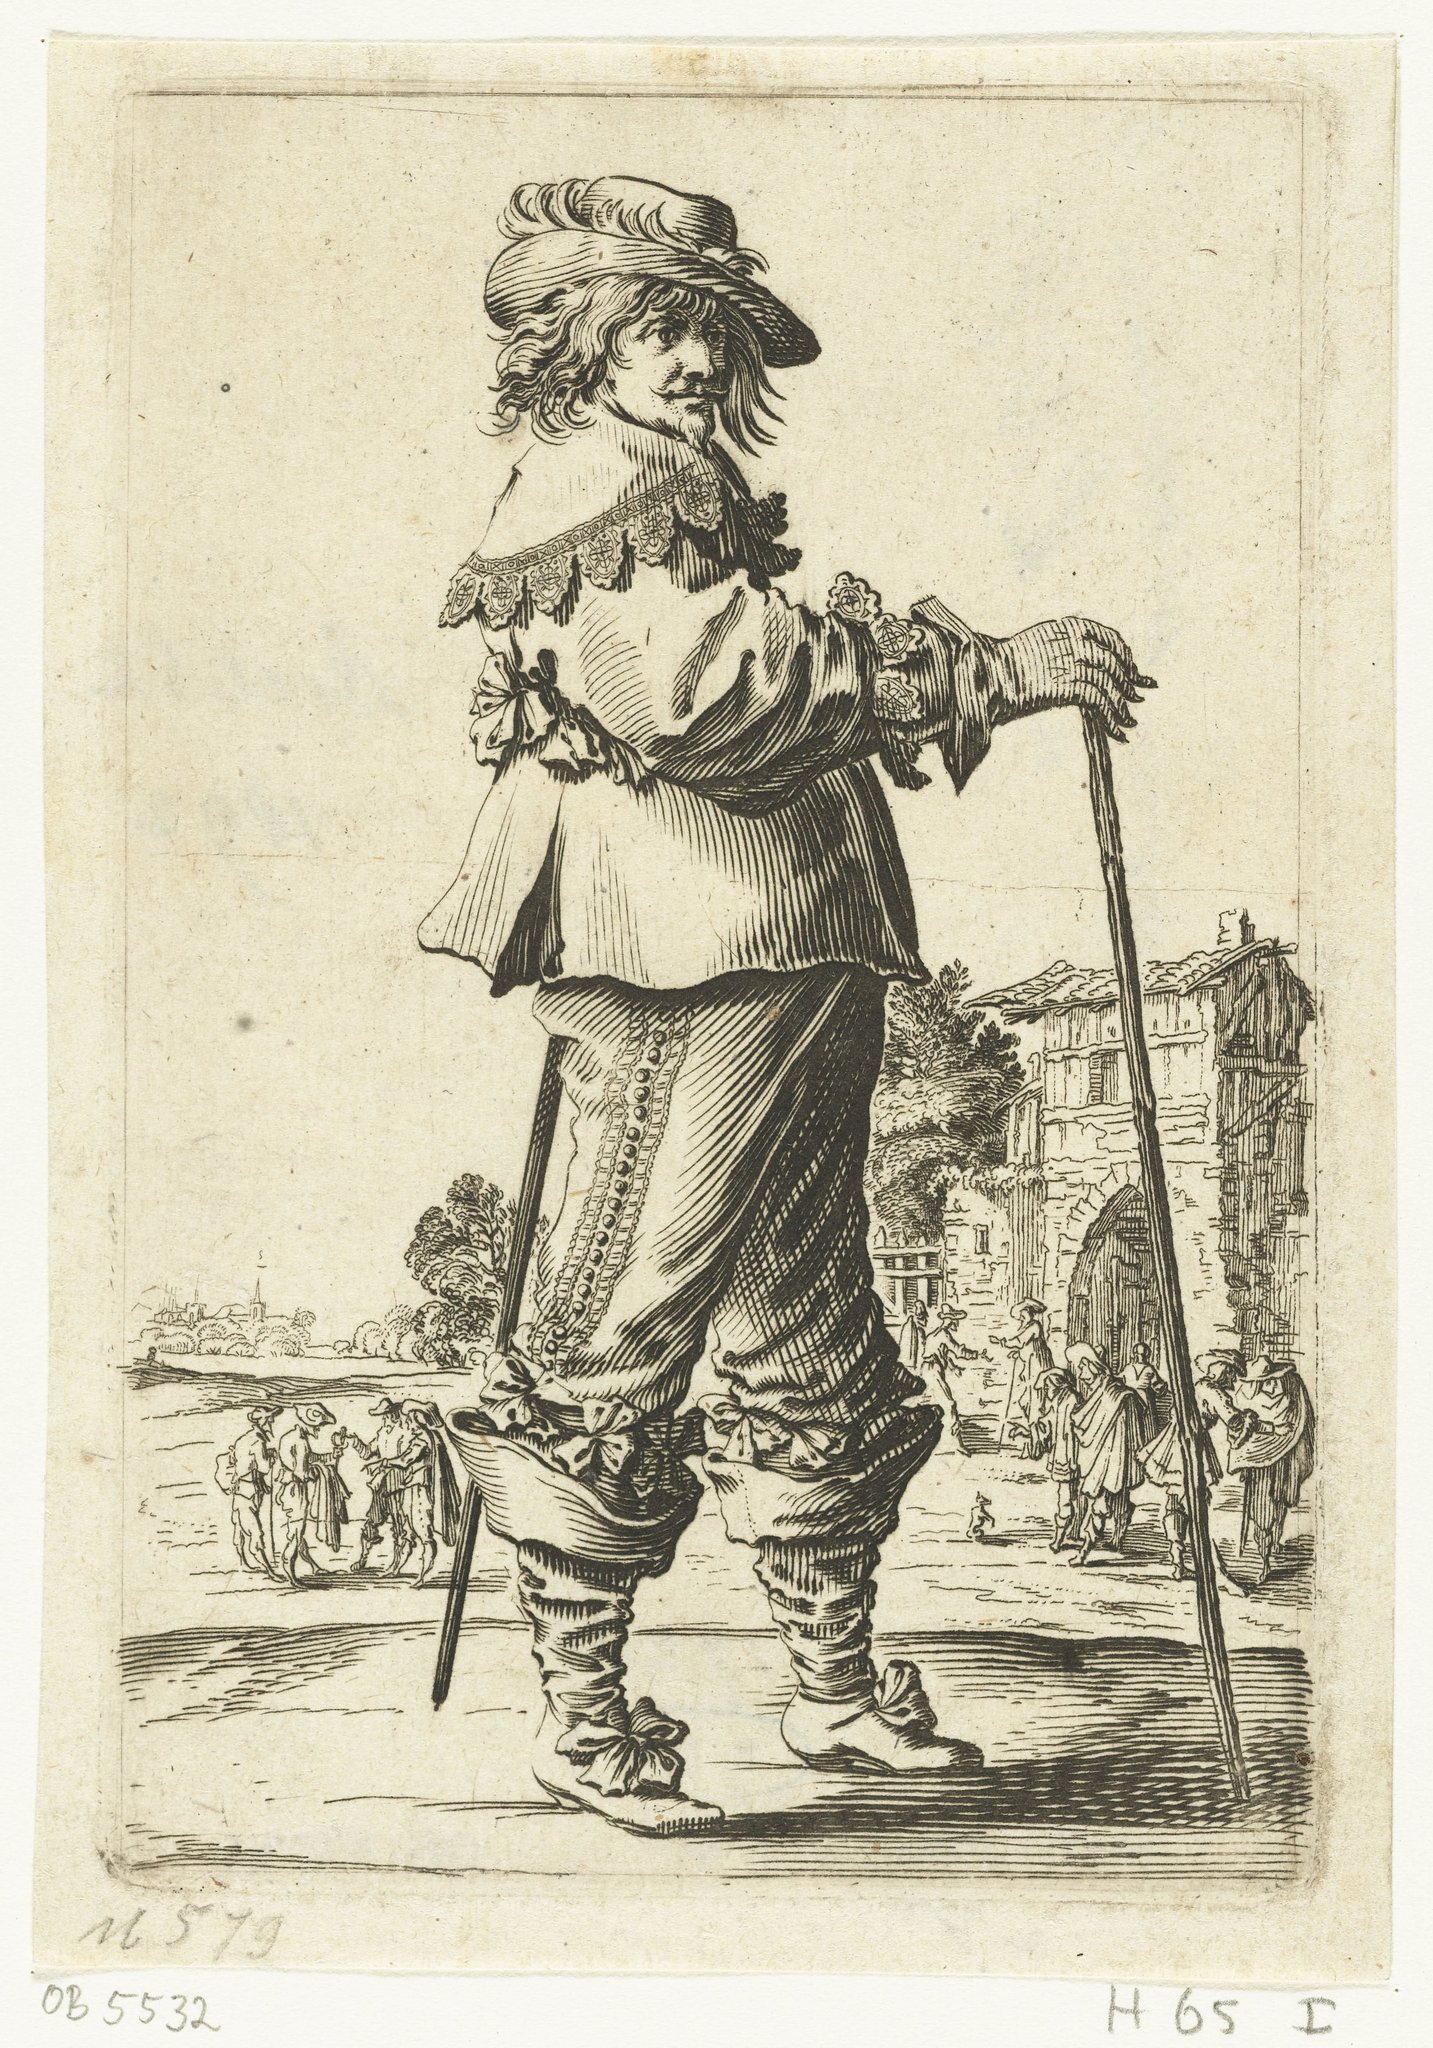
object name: costume print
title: Staande officier met wandelstok, van opzij gezien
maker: salomon savery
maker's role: print maker, publisher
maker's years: 1594-1683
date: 1630-1665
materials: paper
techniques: engraving, etching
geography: amsterdam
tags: bow (ornamental part of clothing) (+ men's clothes), trousers, breeches (+ men's clothes), head-gear: hat (+ men's clothes), hacking and thrusting weapons: sword, clothes, costume (+ men's clothes), officer, neck-gear: collar (+ men's clothes), boots (+ men's clothes), clothing for the upper part of the body (jacket) (+ men's clothes), gloves, mittens, etc. (+ men's clothes), walking-stick, staff, cane (+ men's clothes)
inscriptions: collector's mark: Lugt 2228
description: Officier van opzij gezien, leunend op lange stok. Hij draagt een kort jasje met een strik op de rug, kniebroek en laarzen. Op de achtergrond mensen voor een bouwvallige poort. De prent maakt deel uit van een tiendelige serie met voorstellingen van gewapende officieren en soldaten, gekleed volgens de Nederlandse mode ca. 1625-1635.